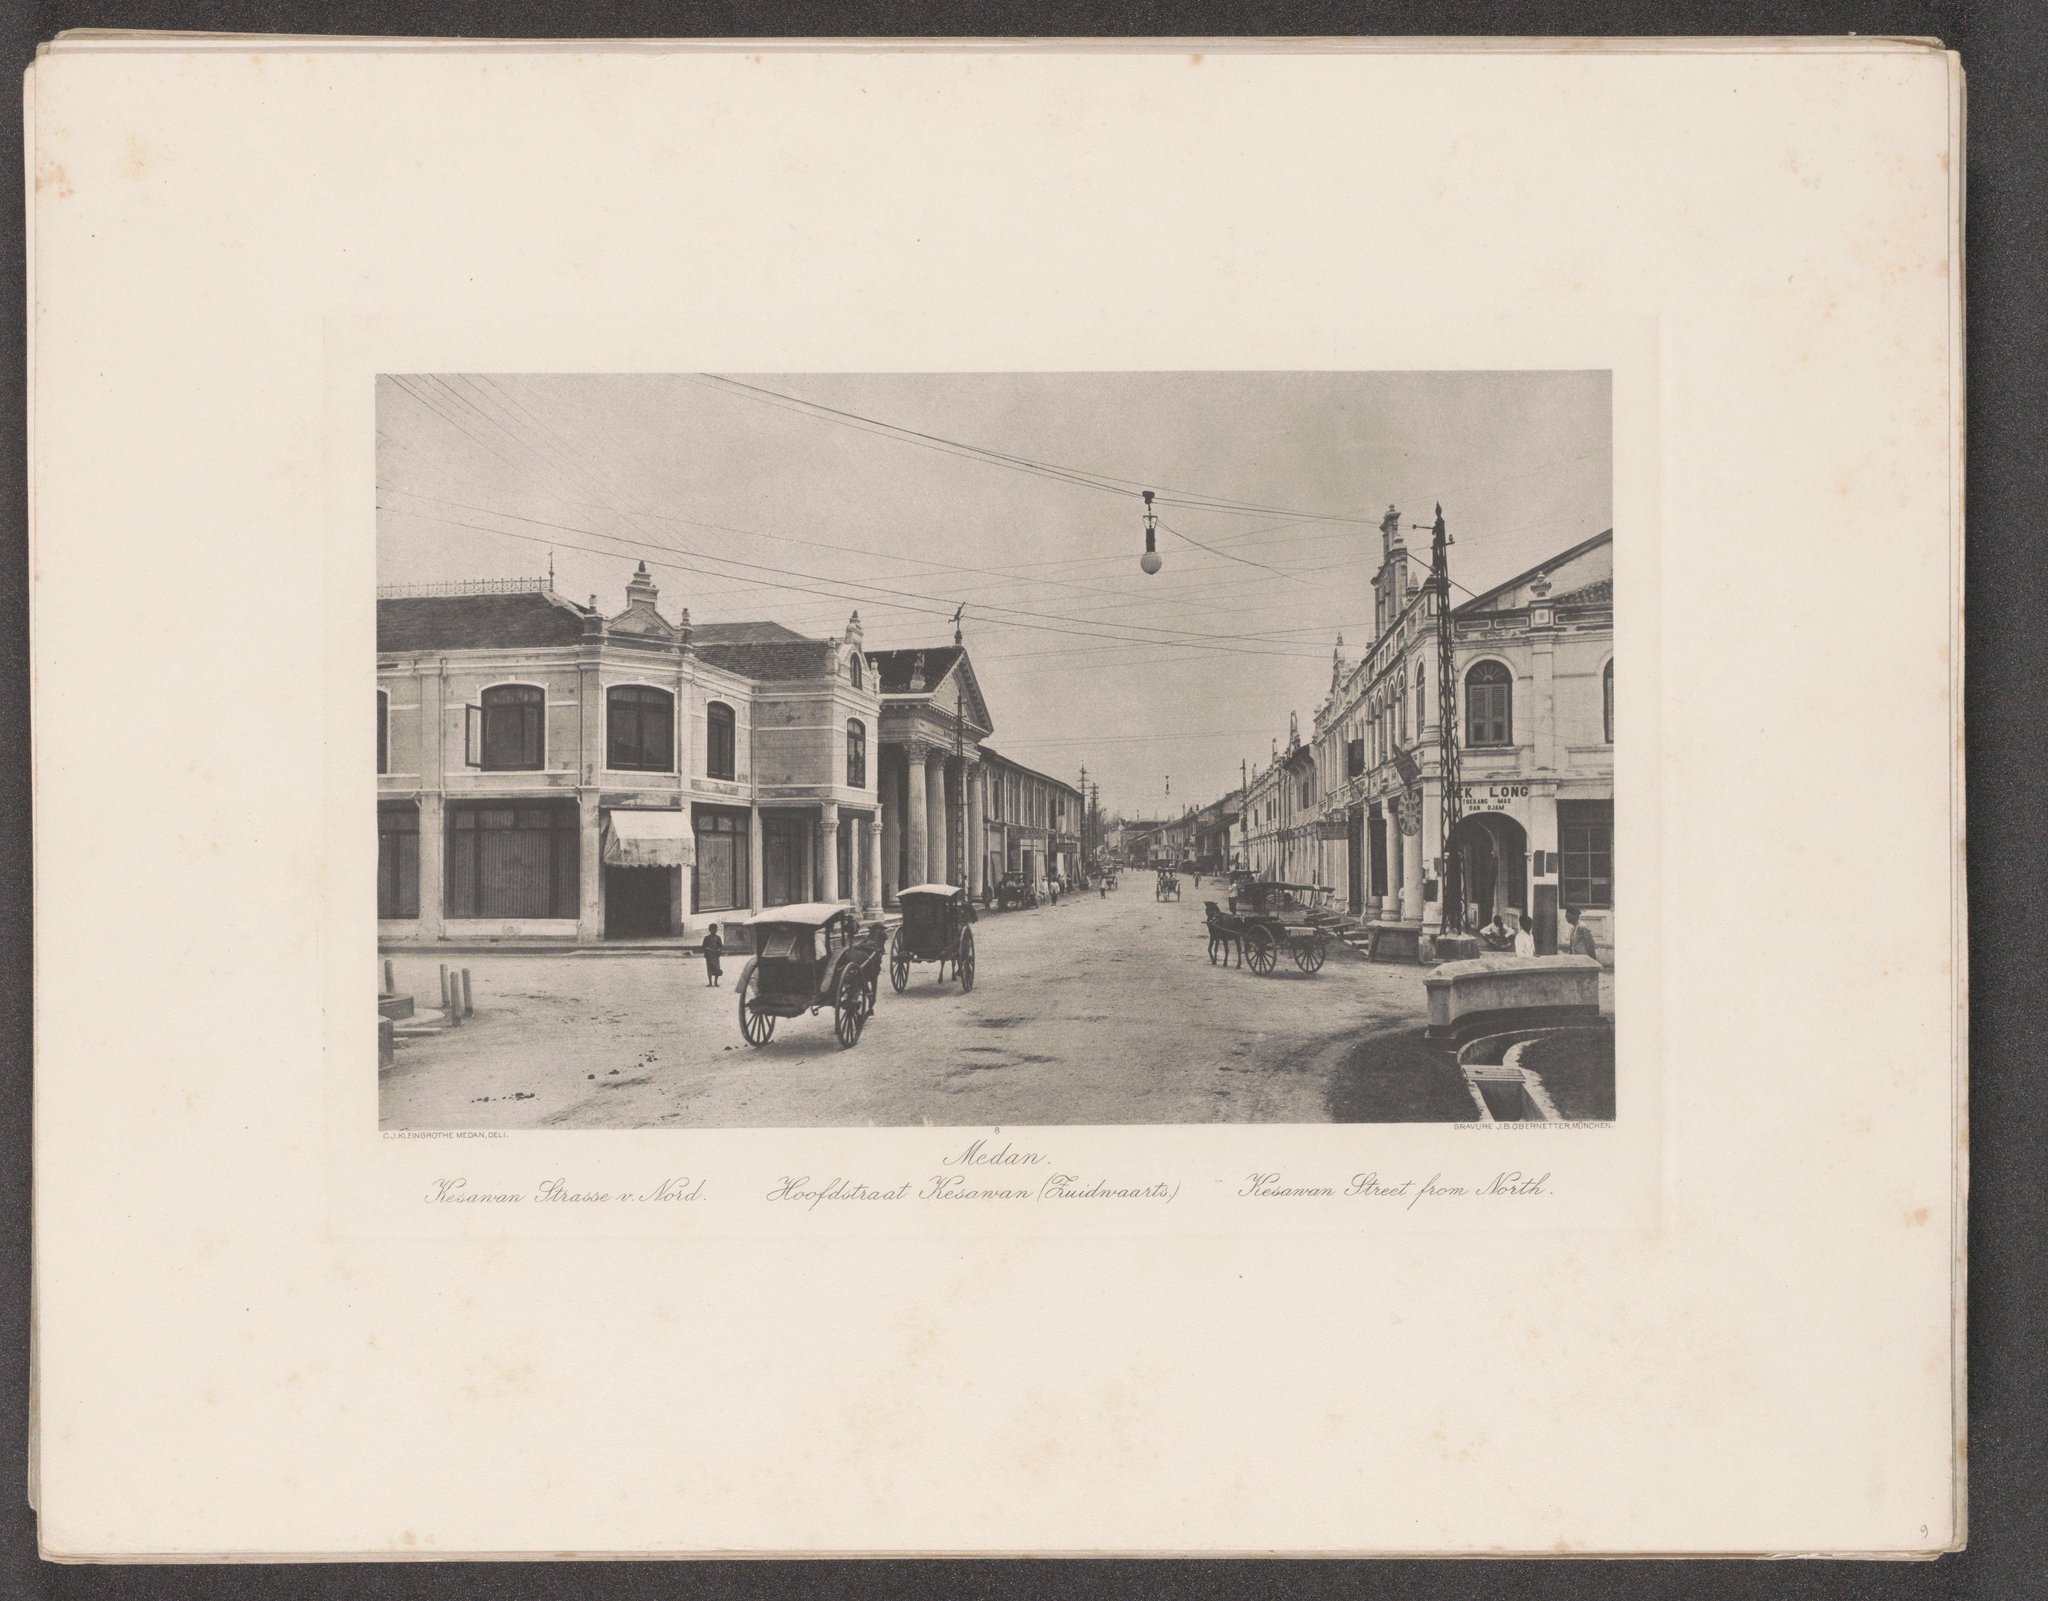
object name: photomechanical print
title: Medan. Hoofdstraat Kesawan (Zuidwaarts)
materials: paper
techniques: photoaquatint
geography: medan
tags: advertising, two-wheeled, animal-drawn vehicle, workshop, hotel, hostelry, inn, street (+ city(-scape) with figures, staffage)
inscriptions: number: ‘8’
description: Onderdeel van Album met heliogravures van Sumatra's oostkust.